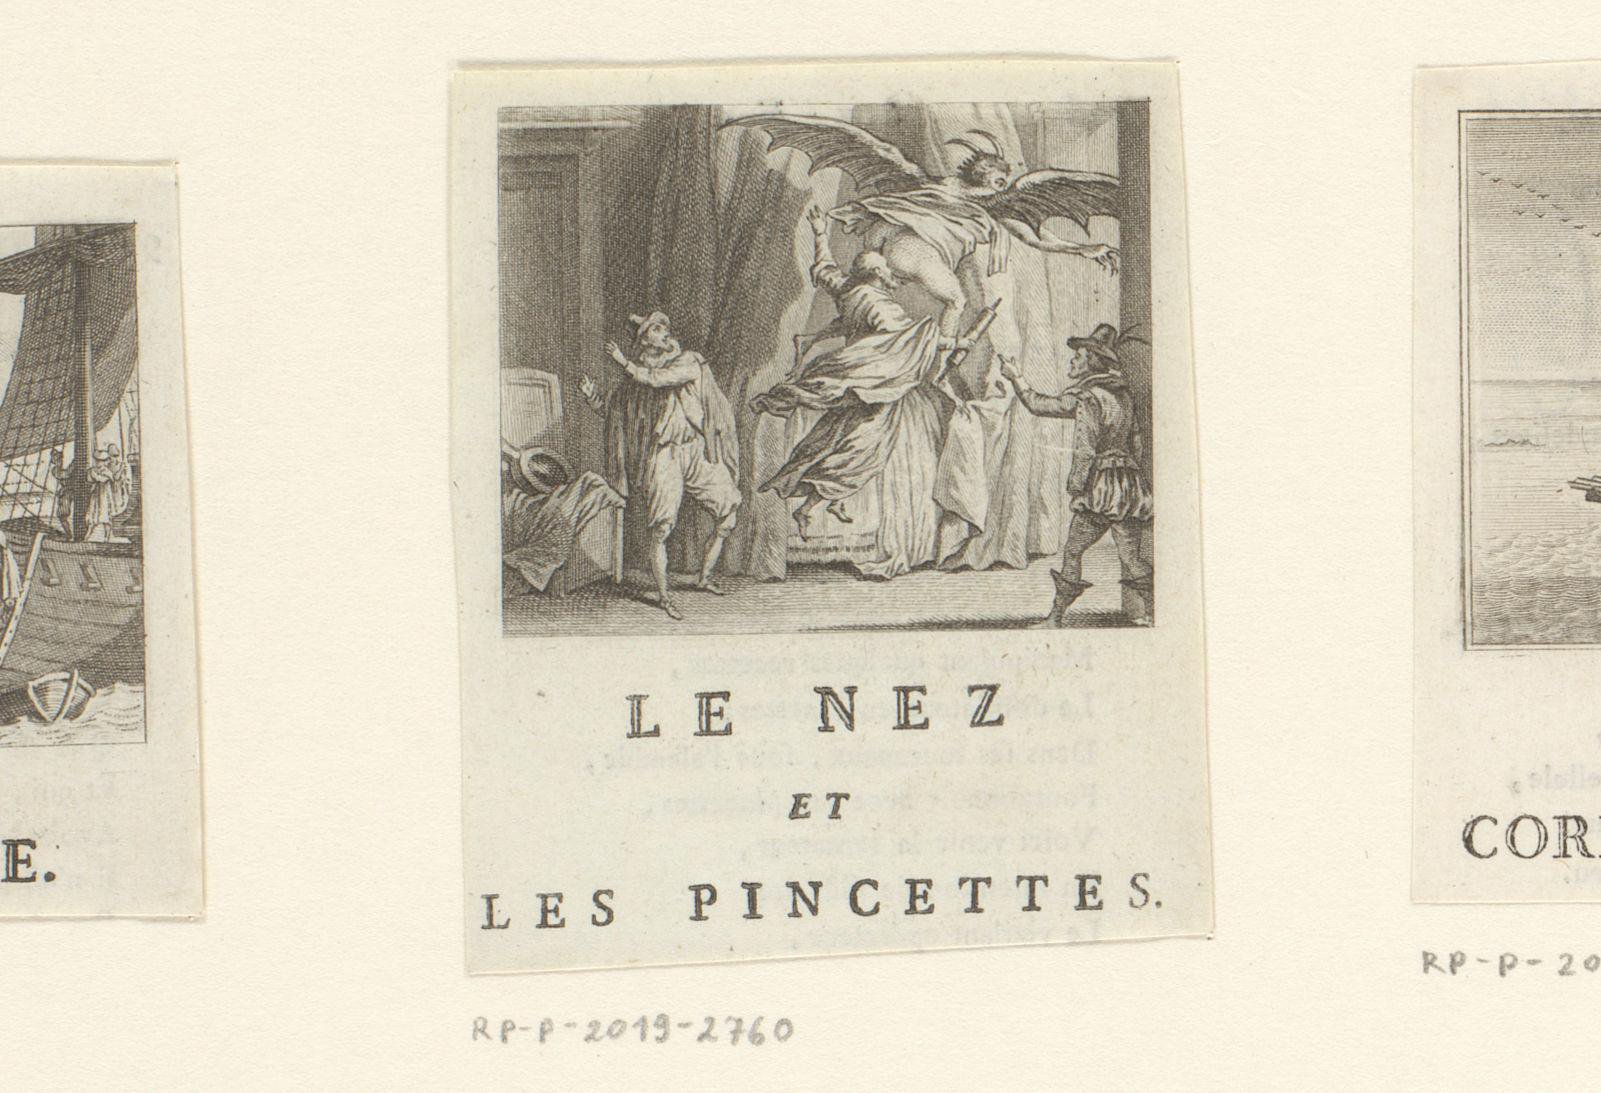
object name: print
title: Le nez et les pincettes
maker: Anonymous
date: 1763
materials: paper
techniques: engraving, etching, letterpress printing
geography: france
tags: injection ~ medicine, activities of devil(s)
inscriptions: collector's mark: Lugt 2228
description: Mogelijk prent uit: Grecourt, Jean Baptiste Joseph Willart de. Oeuvres diverses de M. de Grécourt, nouvelle édition, augmentée d'un grand nombre de pièces, revus sur les originales et du Philotanis. Amsterdam: s.n., 1763.